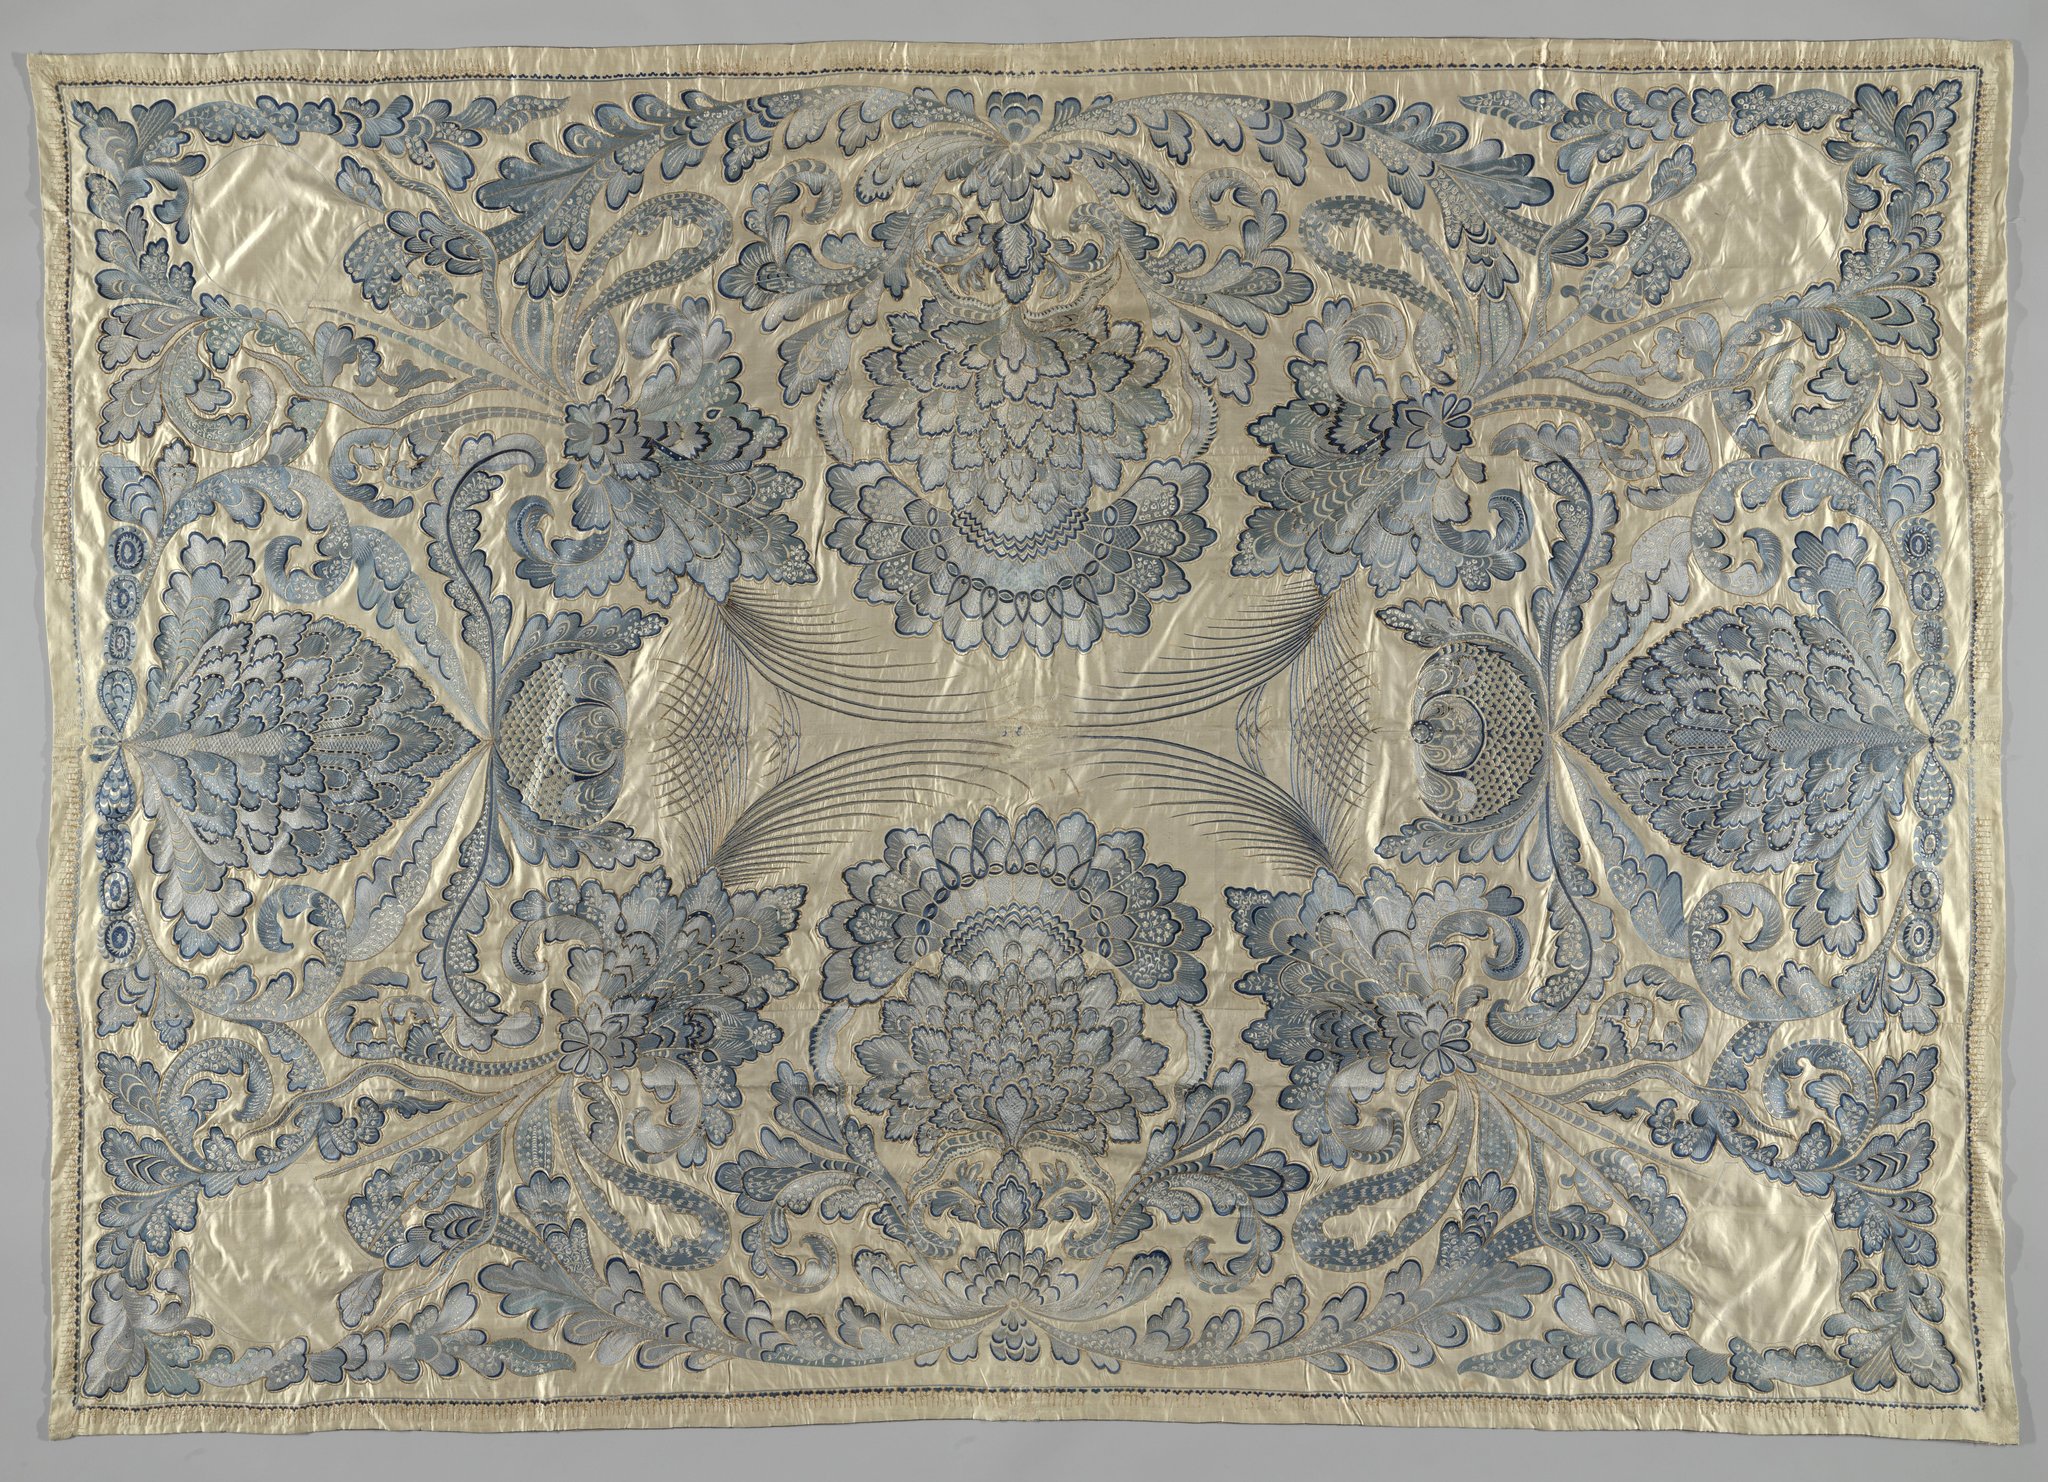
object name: bed covering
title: Bedcover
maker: Anonymous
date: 1710-1720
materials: textile, silk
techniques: embroidered, weave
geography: china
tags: kasteel rosendael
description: This bedcover was once owned by Petronella van Hoorn. She came from a family of governor-generals in Batavia, and her husband, Jan Trip, too, was a VOC governor. The cover was probably given to her by Anthonie Huysman, an ambitious VOC official who hoped to gain the support of his influential relations. His gesture was not in vain, for he was appointed to the Council of the Indies a year after he sent this gift to Petronella.